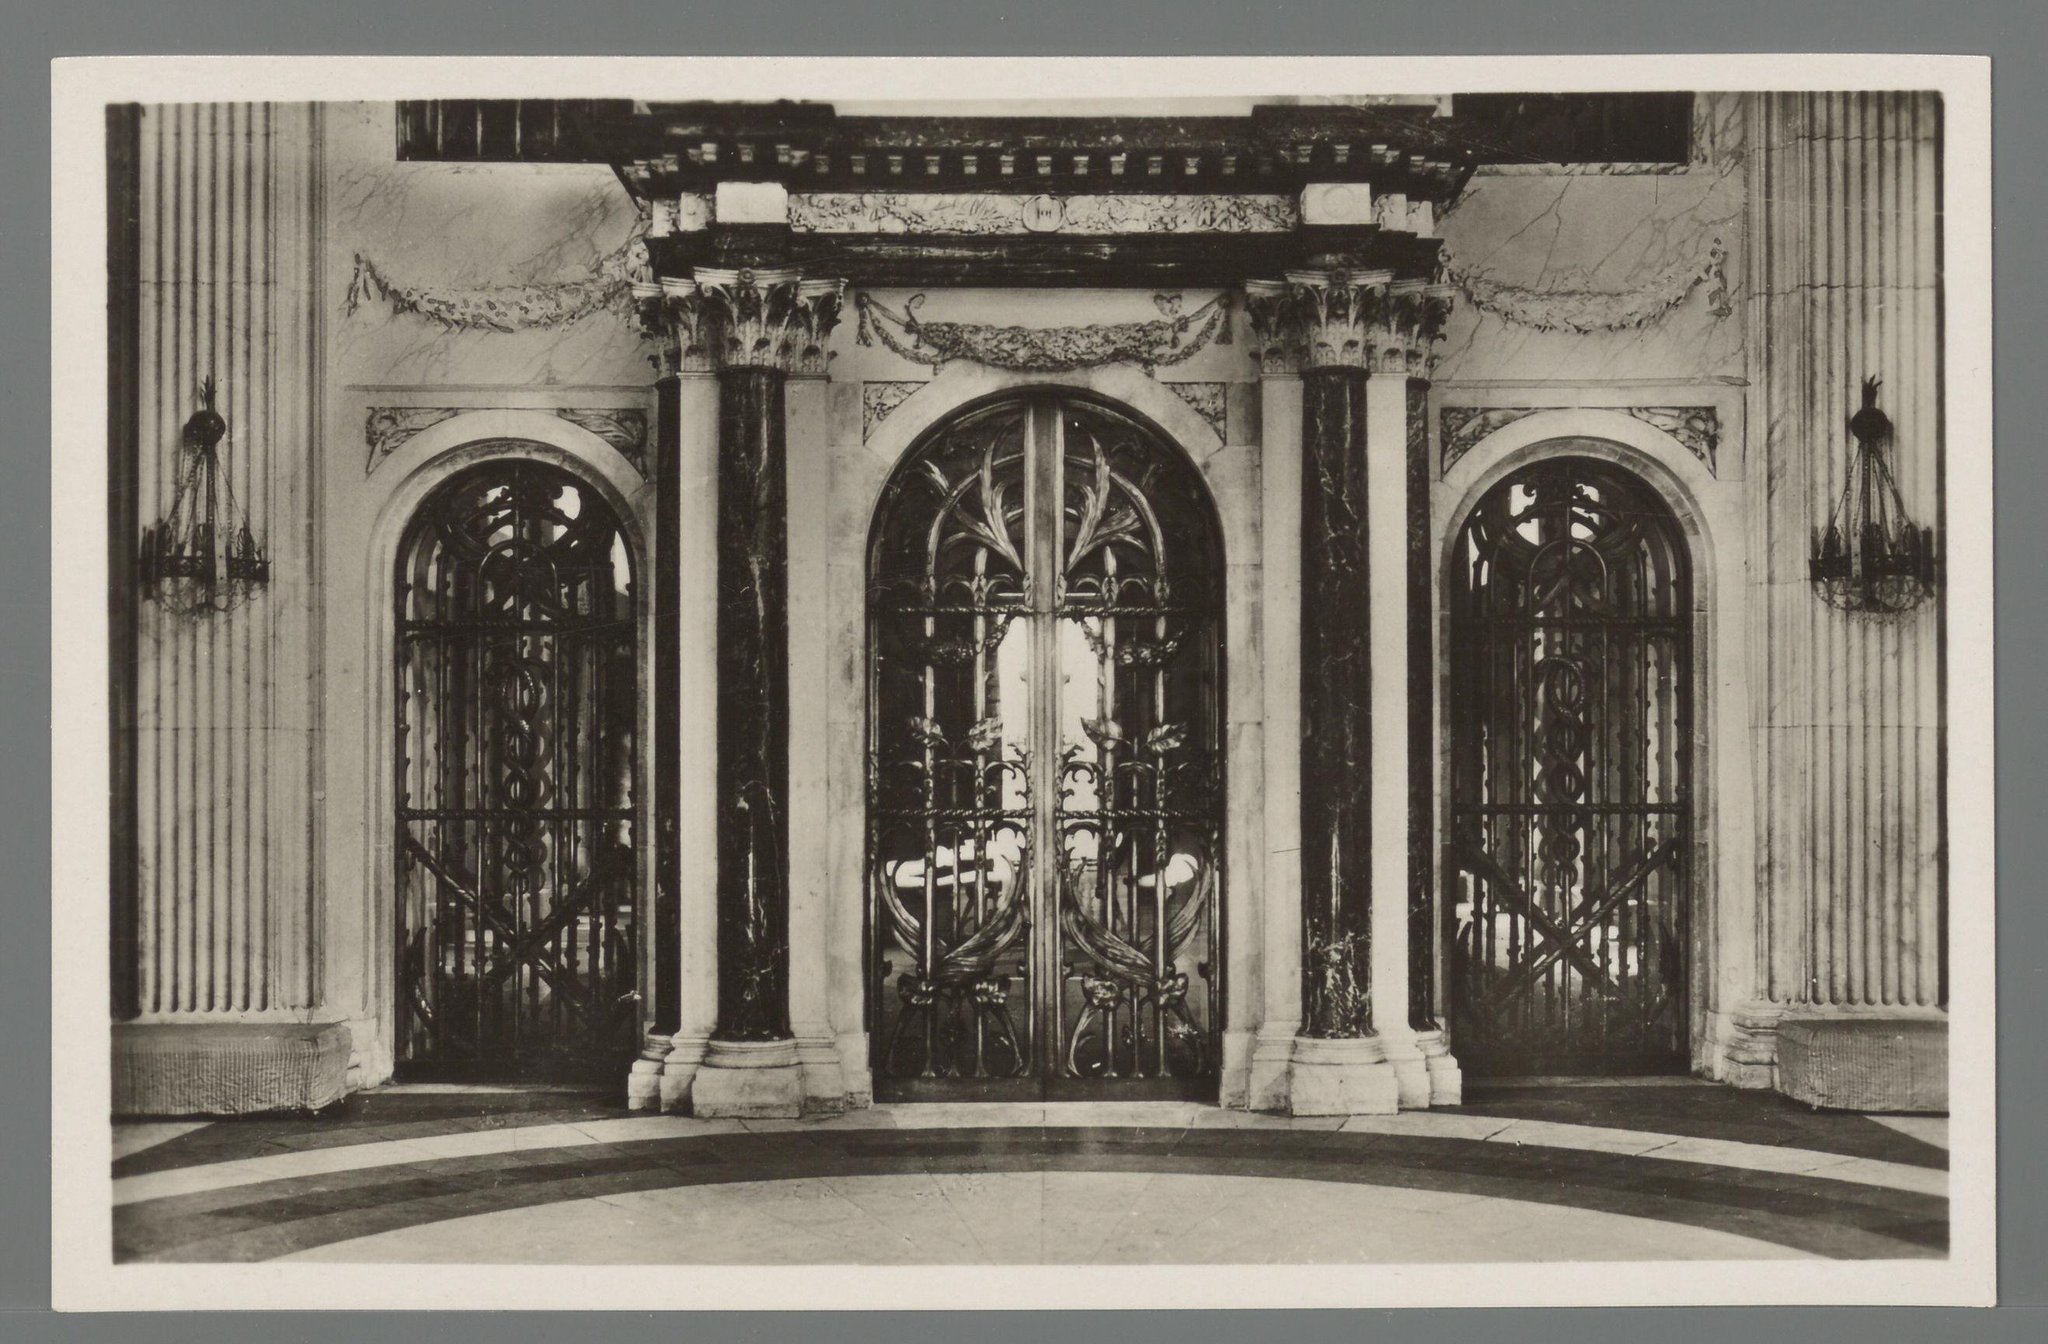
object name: ansichtkaart, prentbriefkaart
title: Koninklijk Paleis Amsterdam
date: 1932-1947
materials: photographic support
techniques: photography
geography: amsterdam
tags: palace - aa - civic architecture: inside, decorations (interior of the house), gate, entrance, royal palace of amsterdam